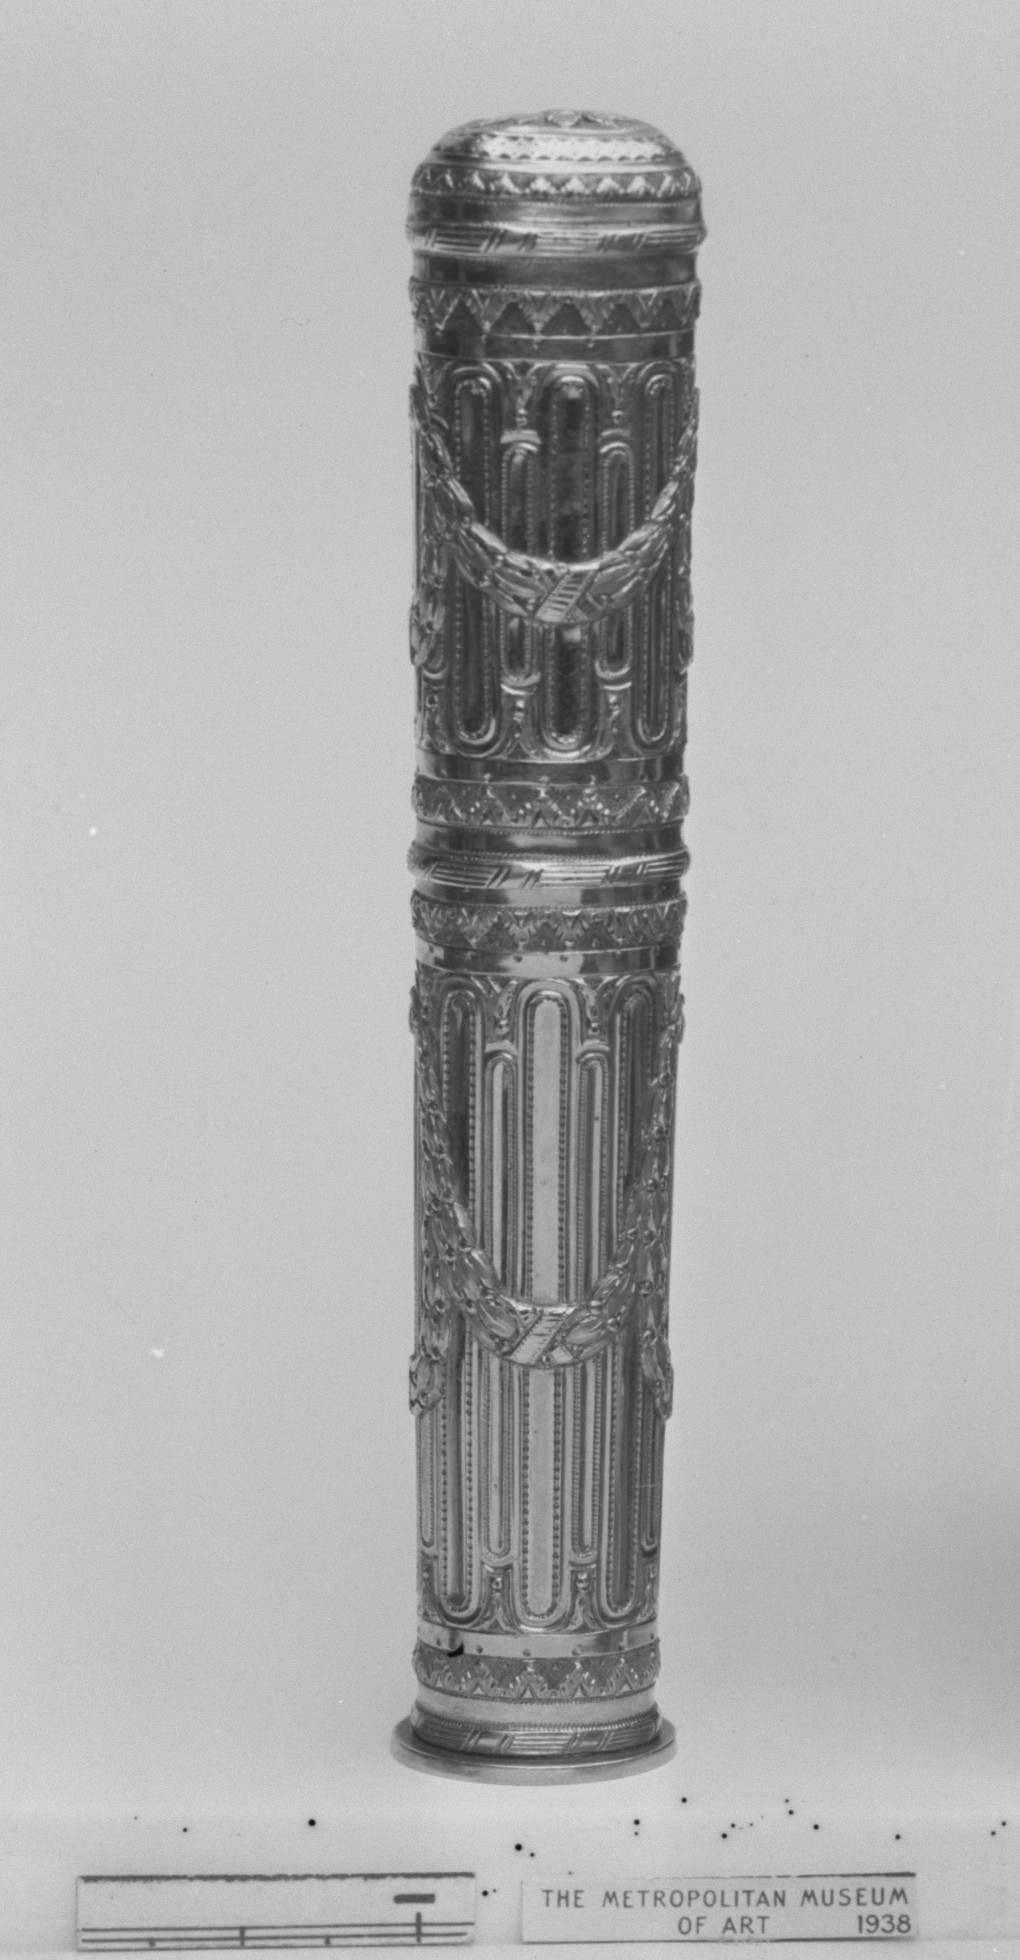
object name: étui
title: Sealing wax case (étui)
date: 1775-1781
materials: gold